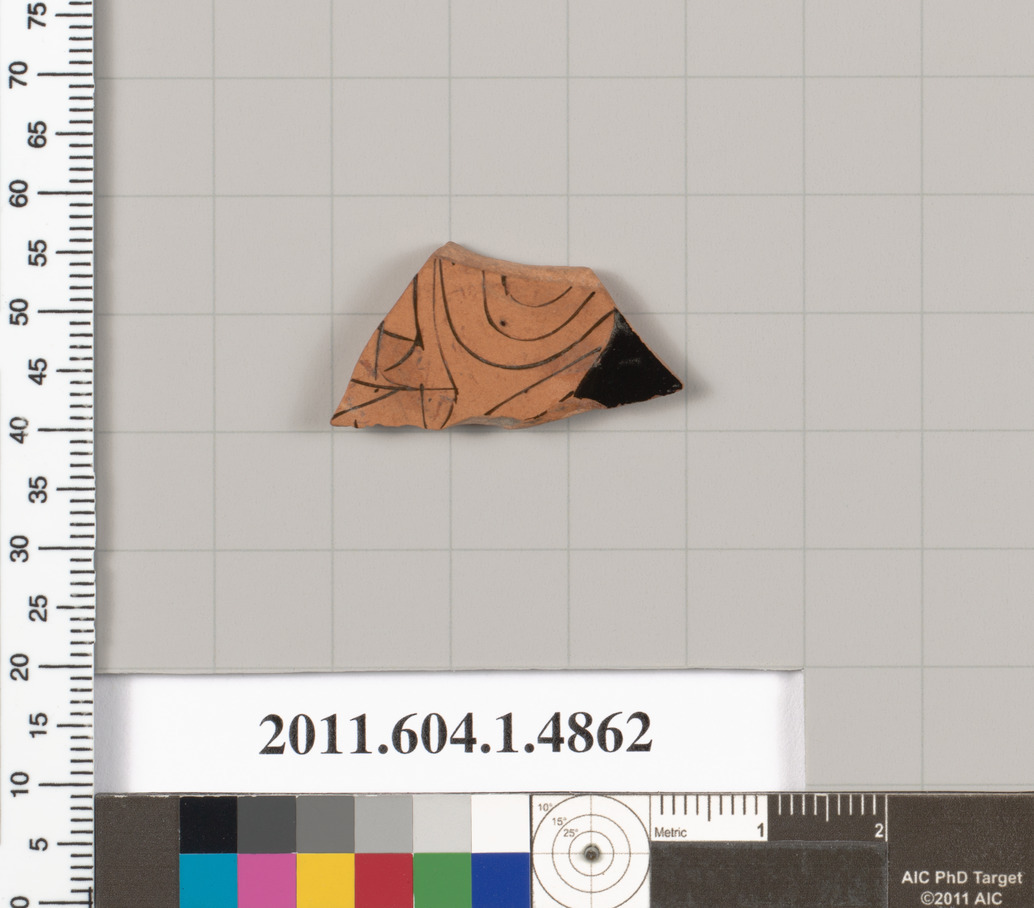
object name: kylix fragment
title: Terracotta fragment of a kylix (drinking cup)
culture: greek, attic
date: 480-470 BCE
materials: terracotta